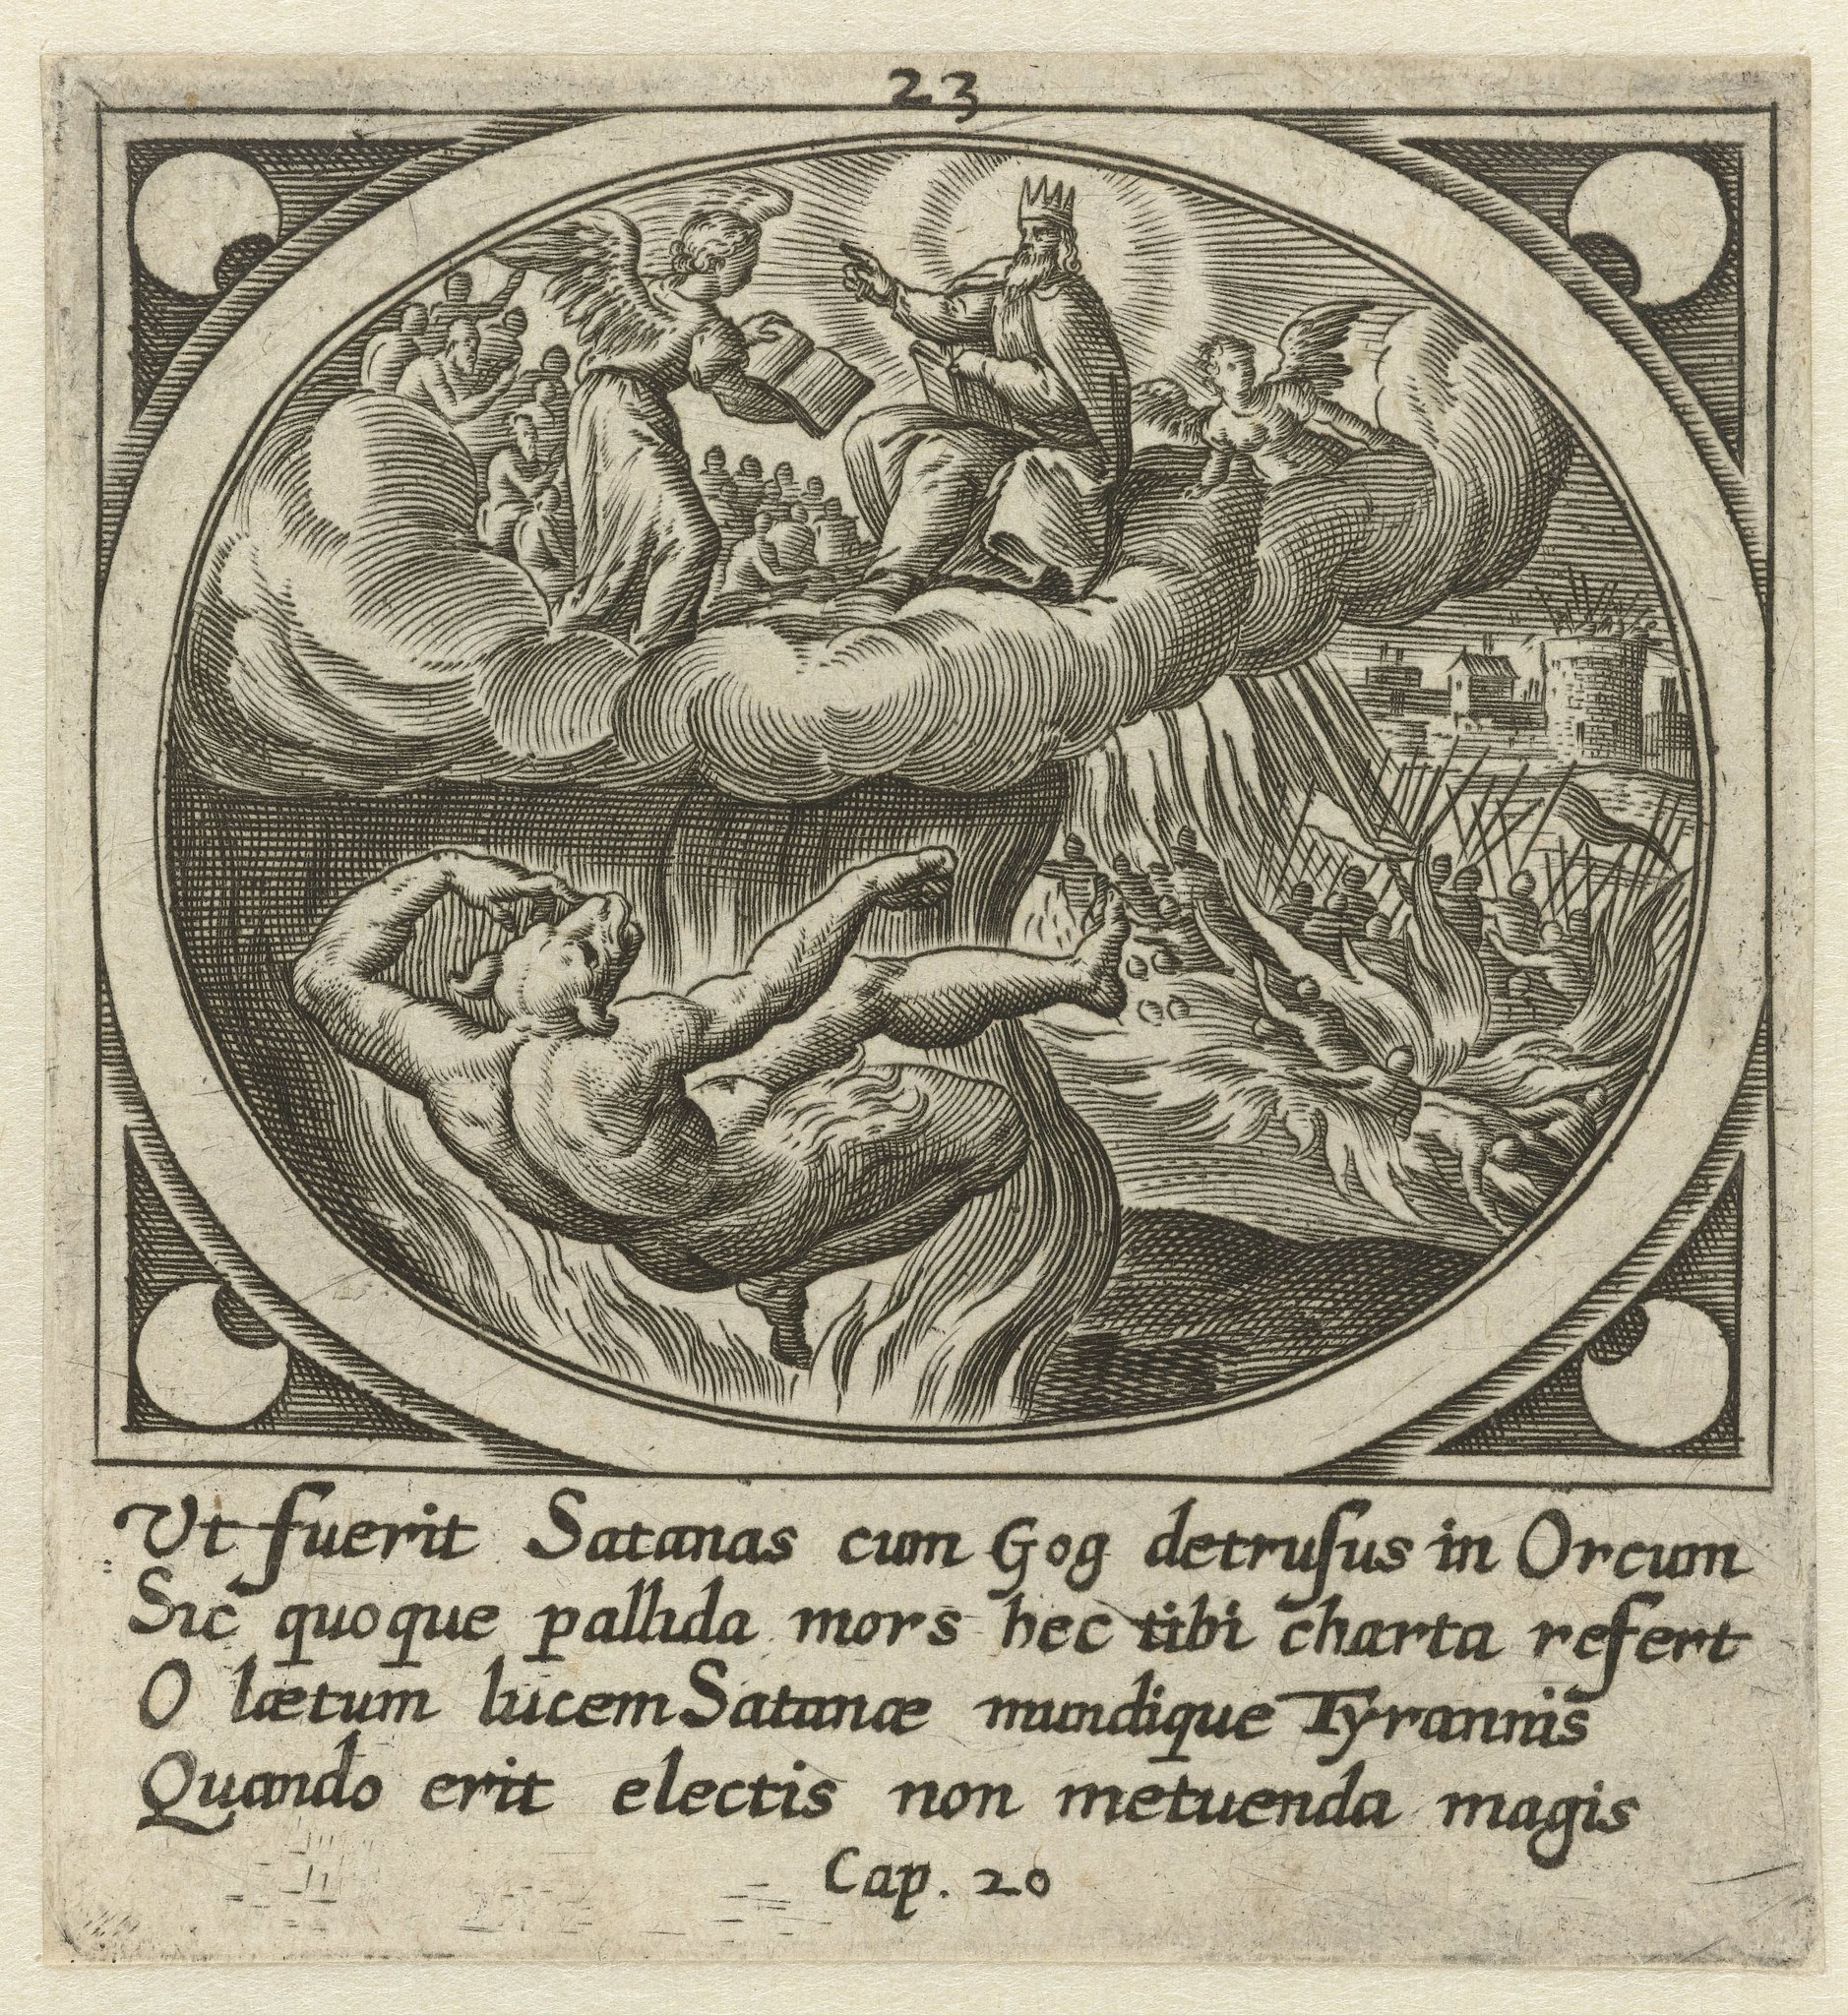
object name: print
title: Icones Revelationum S Johs Evangeliste in Pathmo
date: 1585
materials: paper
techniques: engraving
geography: antwerp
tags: fire from heaven devours satan, gog and magog, and satan is cast into a lake of fire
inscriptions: collector's mark: Lugt 2760, collector's mark: Lugt 2228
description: Hemel met God de Vader, zittend op troon, omringd door doden. Tegenover hem staat een engel met een open boek. Op de achtergrond wordt iedereen die niet in het boek van het leven blijkt te staan in de vuurpoel gegooid (de tweede dood). De duivel, na duizend jaar weer bevrijd, wordt in de poel van vuur en zwavel geworpen. In de marge een vierregelig onderschrift in het Latijn. Drieëntwintigste prent uit een serie van vierentwintig met de openbaring van Johannes op Patmos.